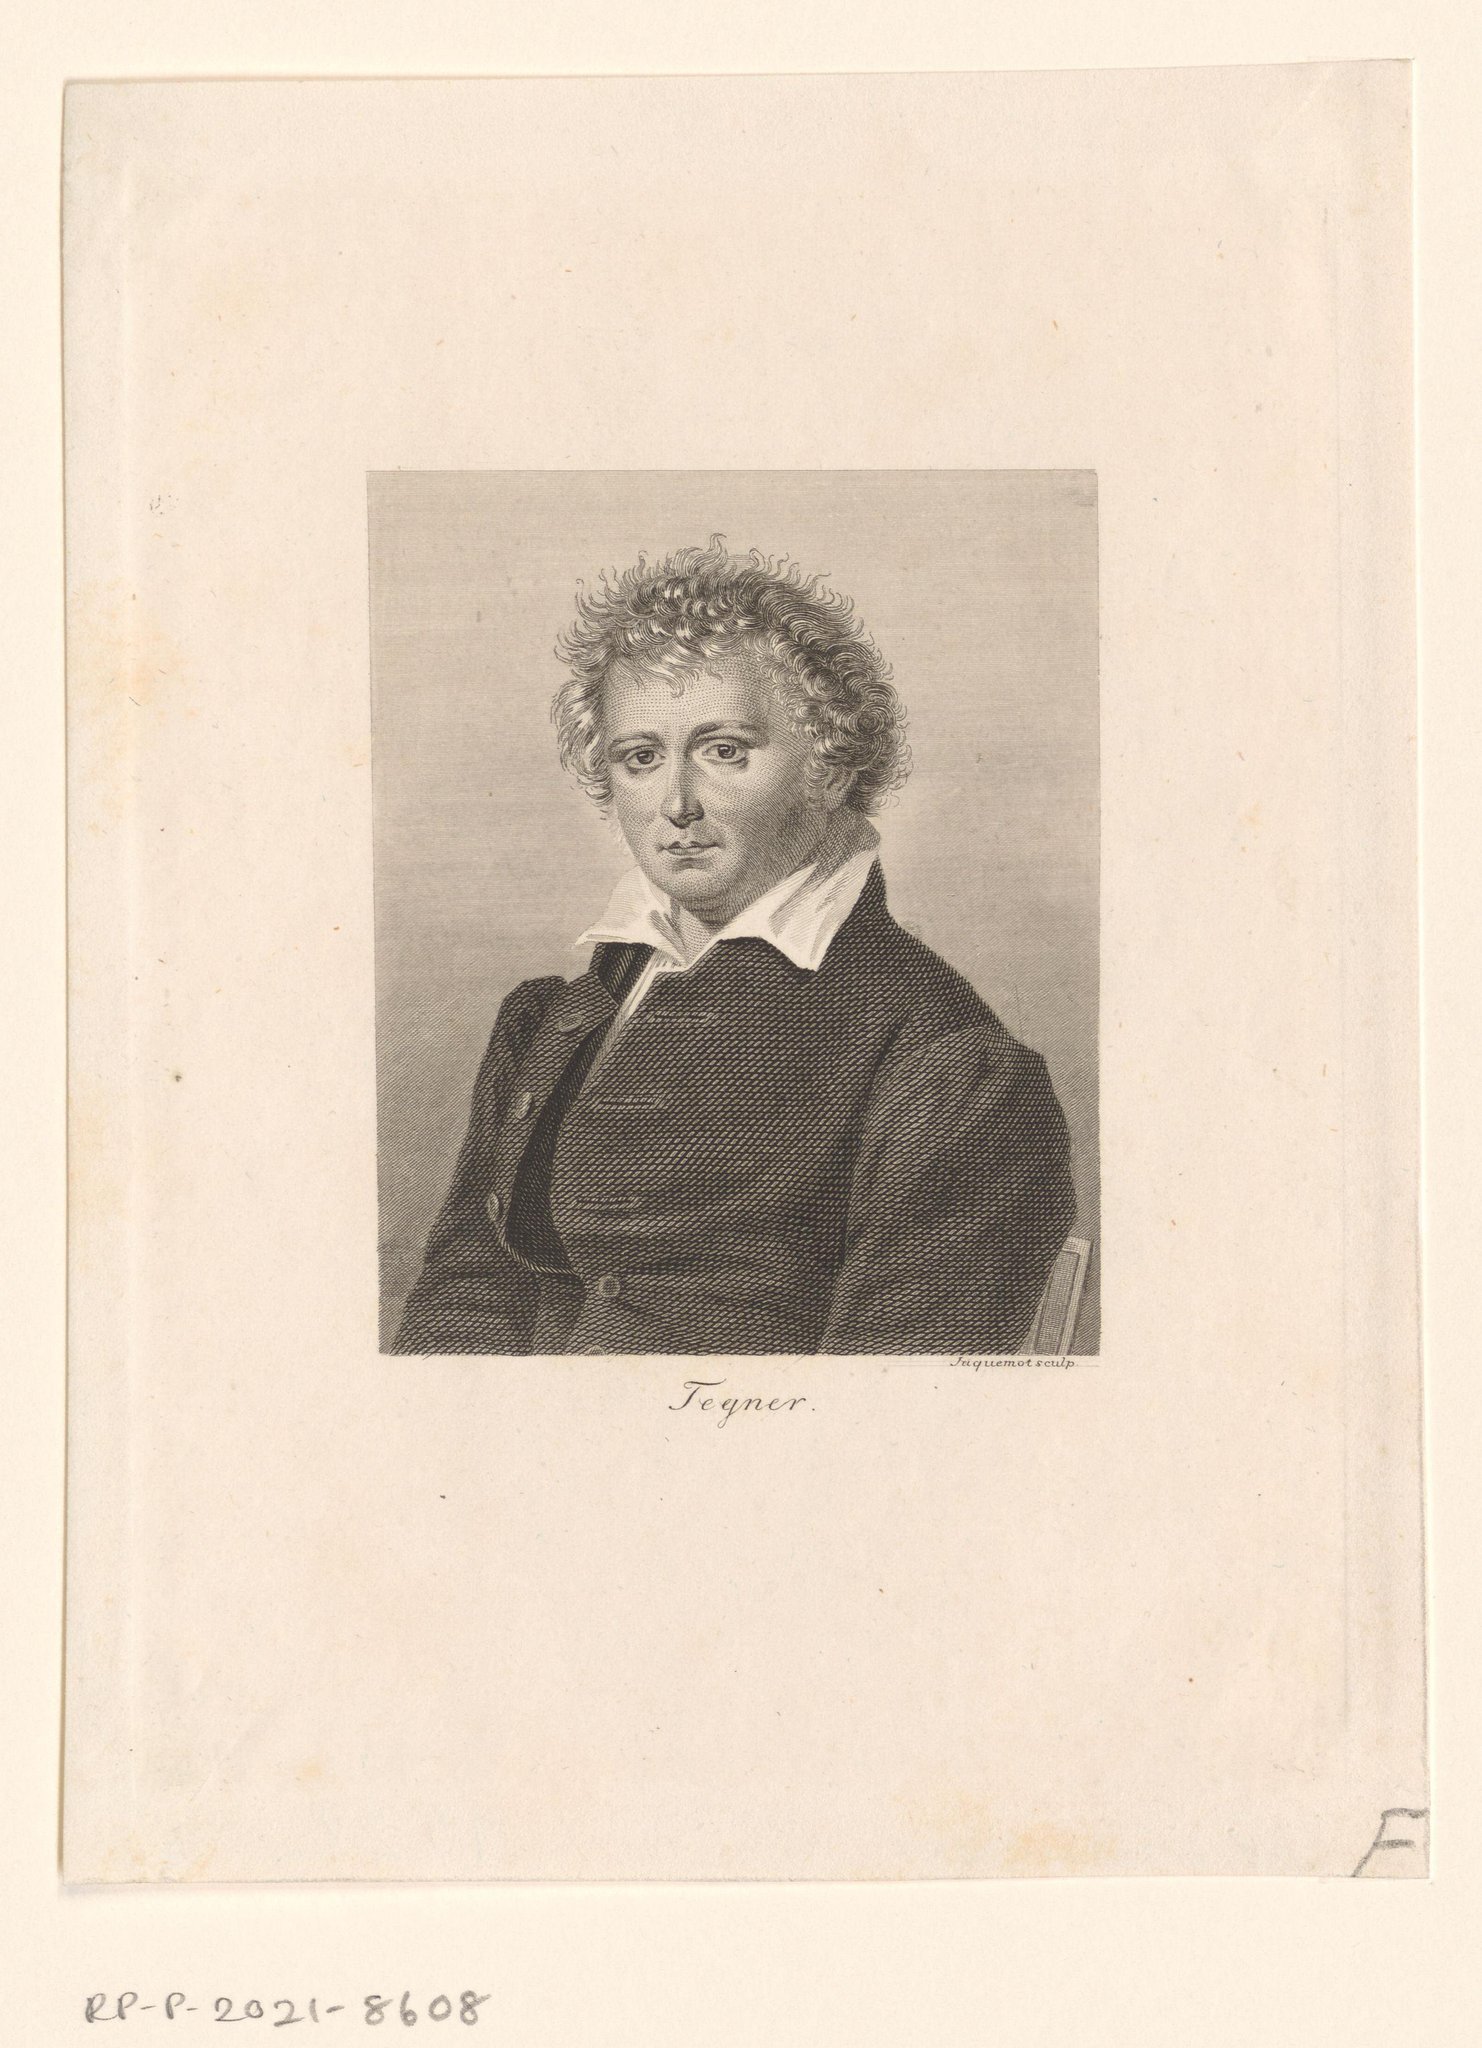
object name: print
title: Portret van Esaias Tegnér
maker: george françois louis jaquemot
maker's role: print maker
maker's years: 1806-1880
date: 1816-1880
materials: paper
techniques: etching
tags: esaias tegnér, historical persons, writer, poet, author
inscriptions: collector's mark: Lugt 2228